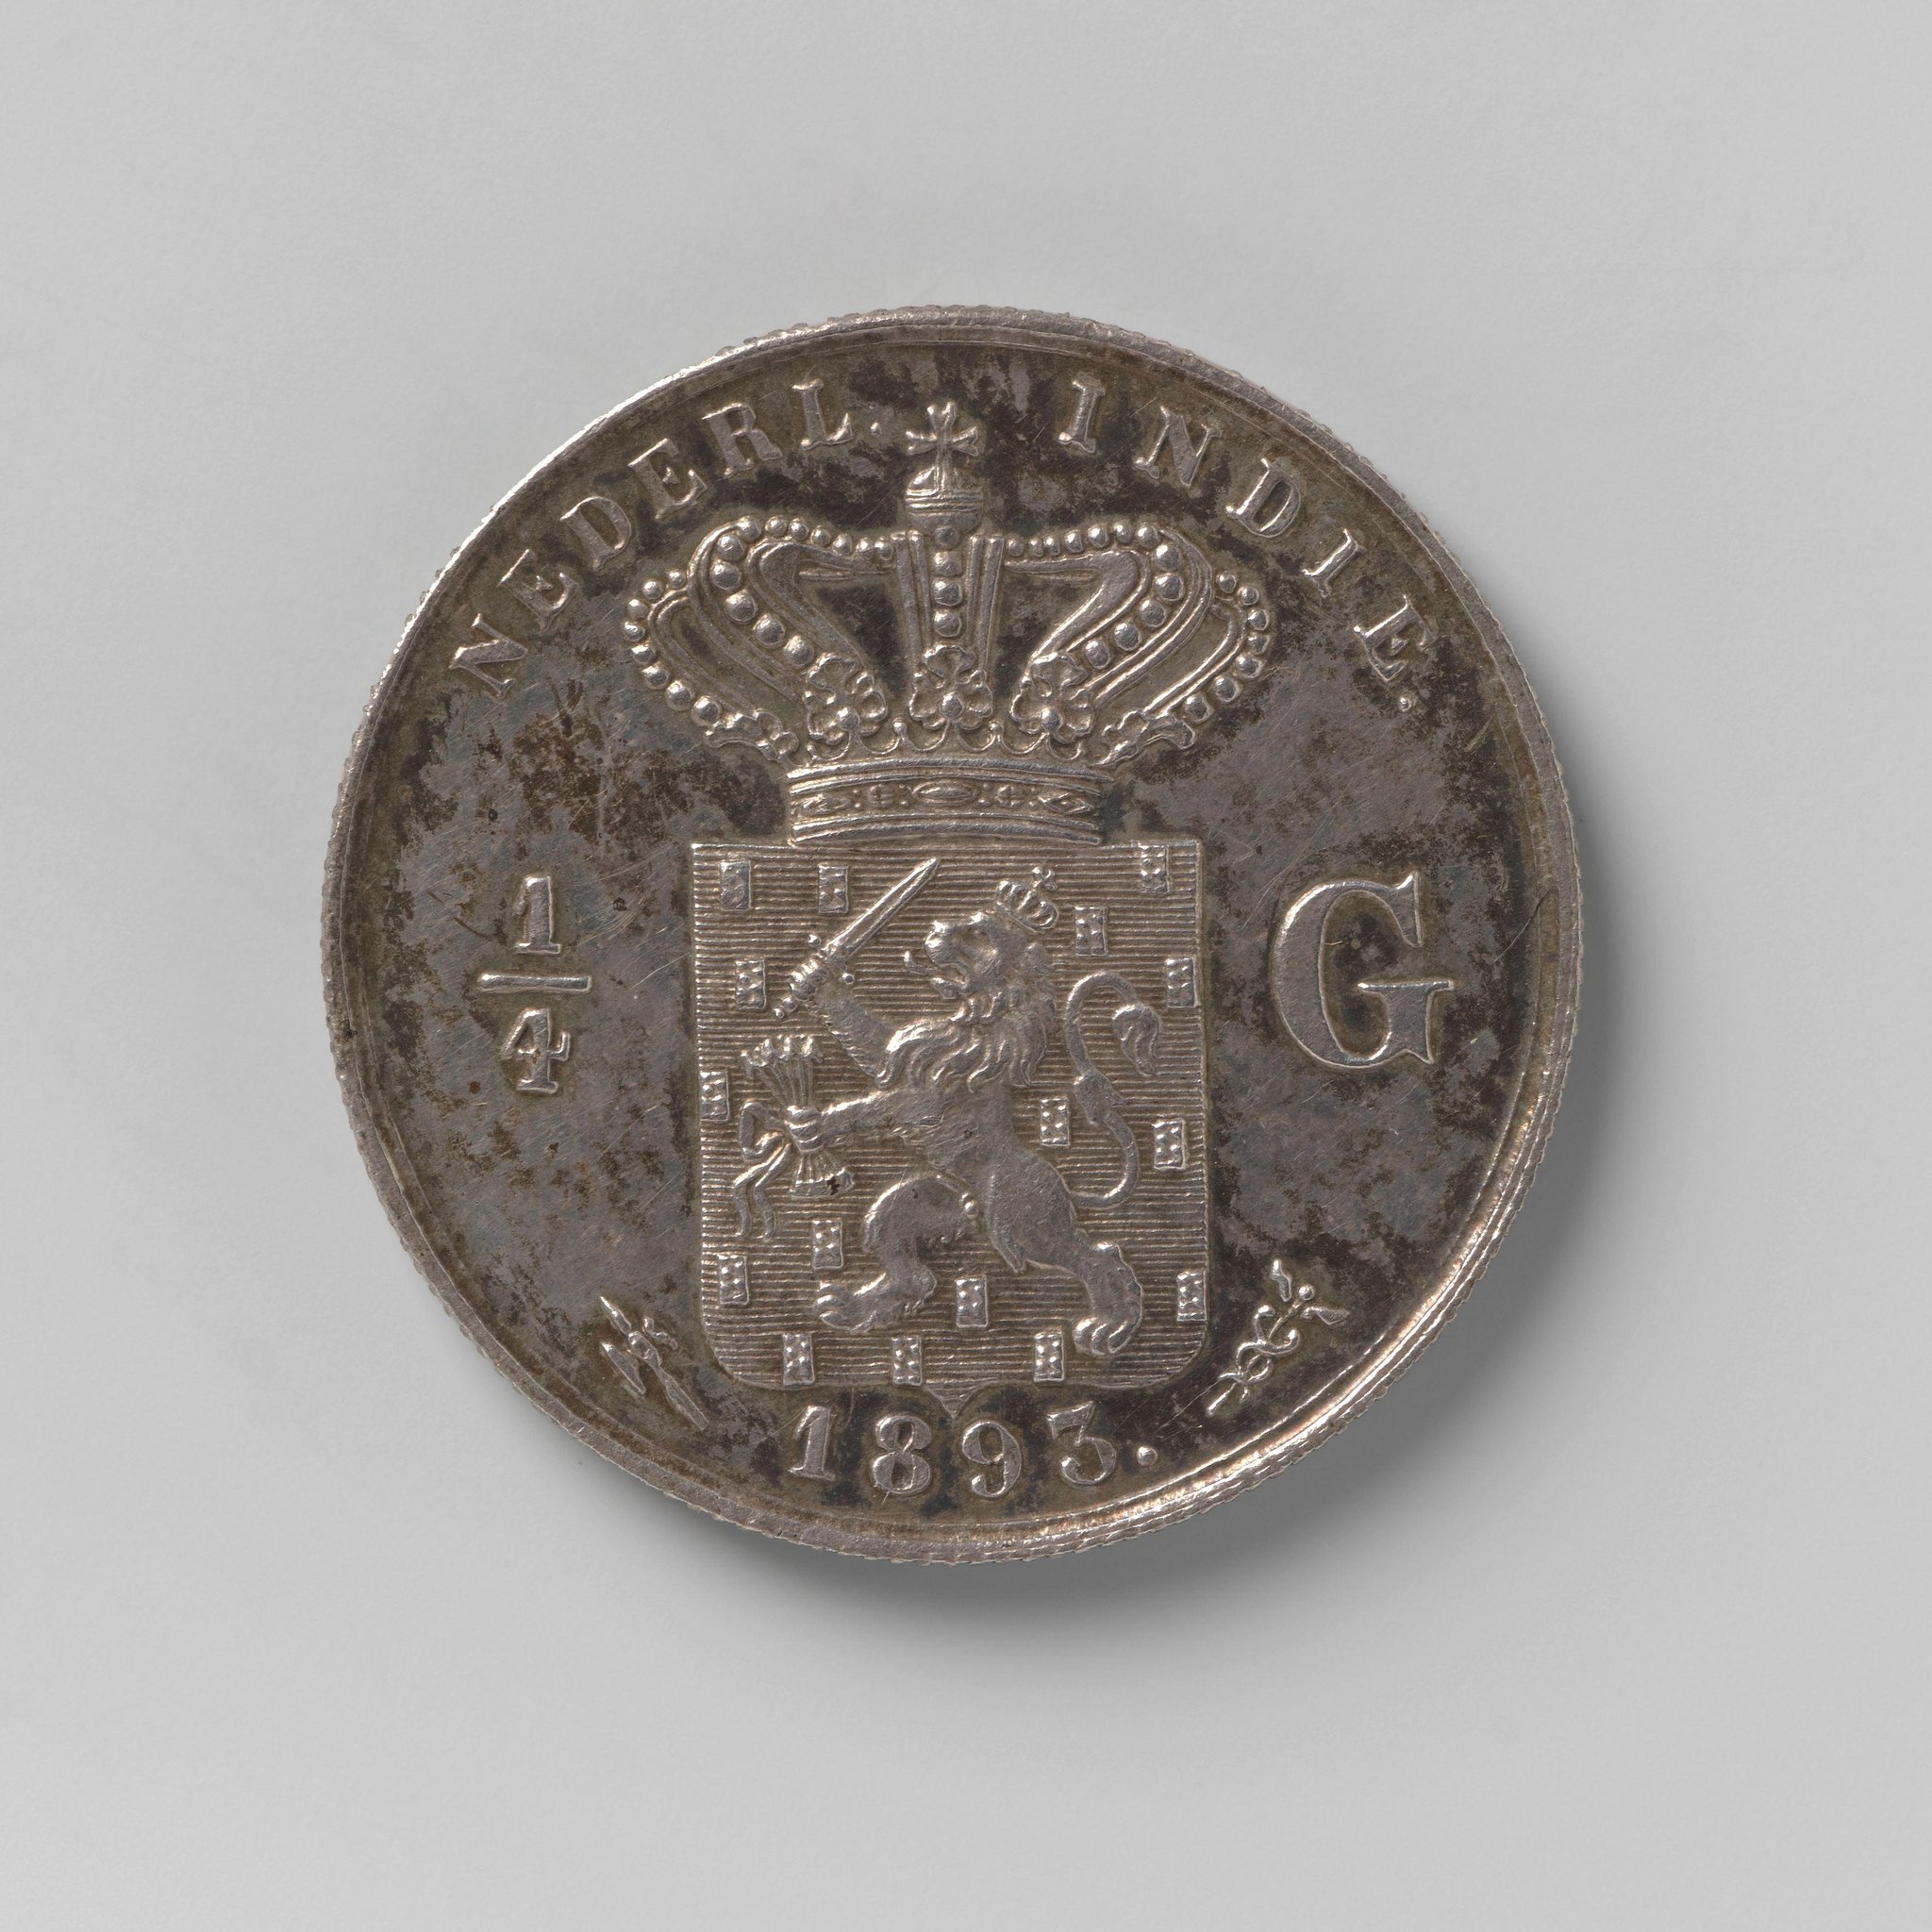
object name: coin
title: Nederlands Indië,1/4 gulden,1893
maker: wilhelmina of the netherlands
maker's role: print maker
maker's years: 1880-1962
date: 1893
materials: silver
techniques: striking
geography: utrecht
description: Zilveren munt. Voorzijde: tussen waarde-aanduiding 1/4 G gekroond rijkswapenschild. Boven kroon landsaanduiding en onder wapenschild jaartal. Keerzijde: drieregelig Maleis opschrift in Arabische tekens, waaromheen tussen zeven uitschietende stralen omschrift in het Javaans. Kartelrand.